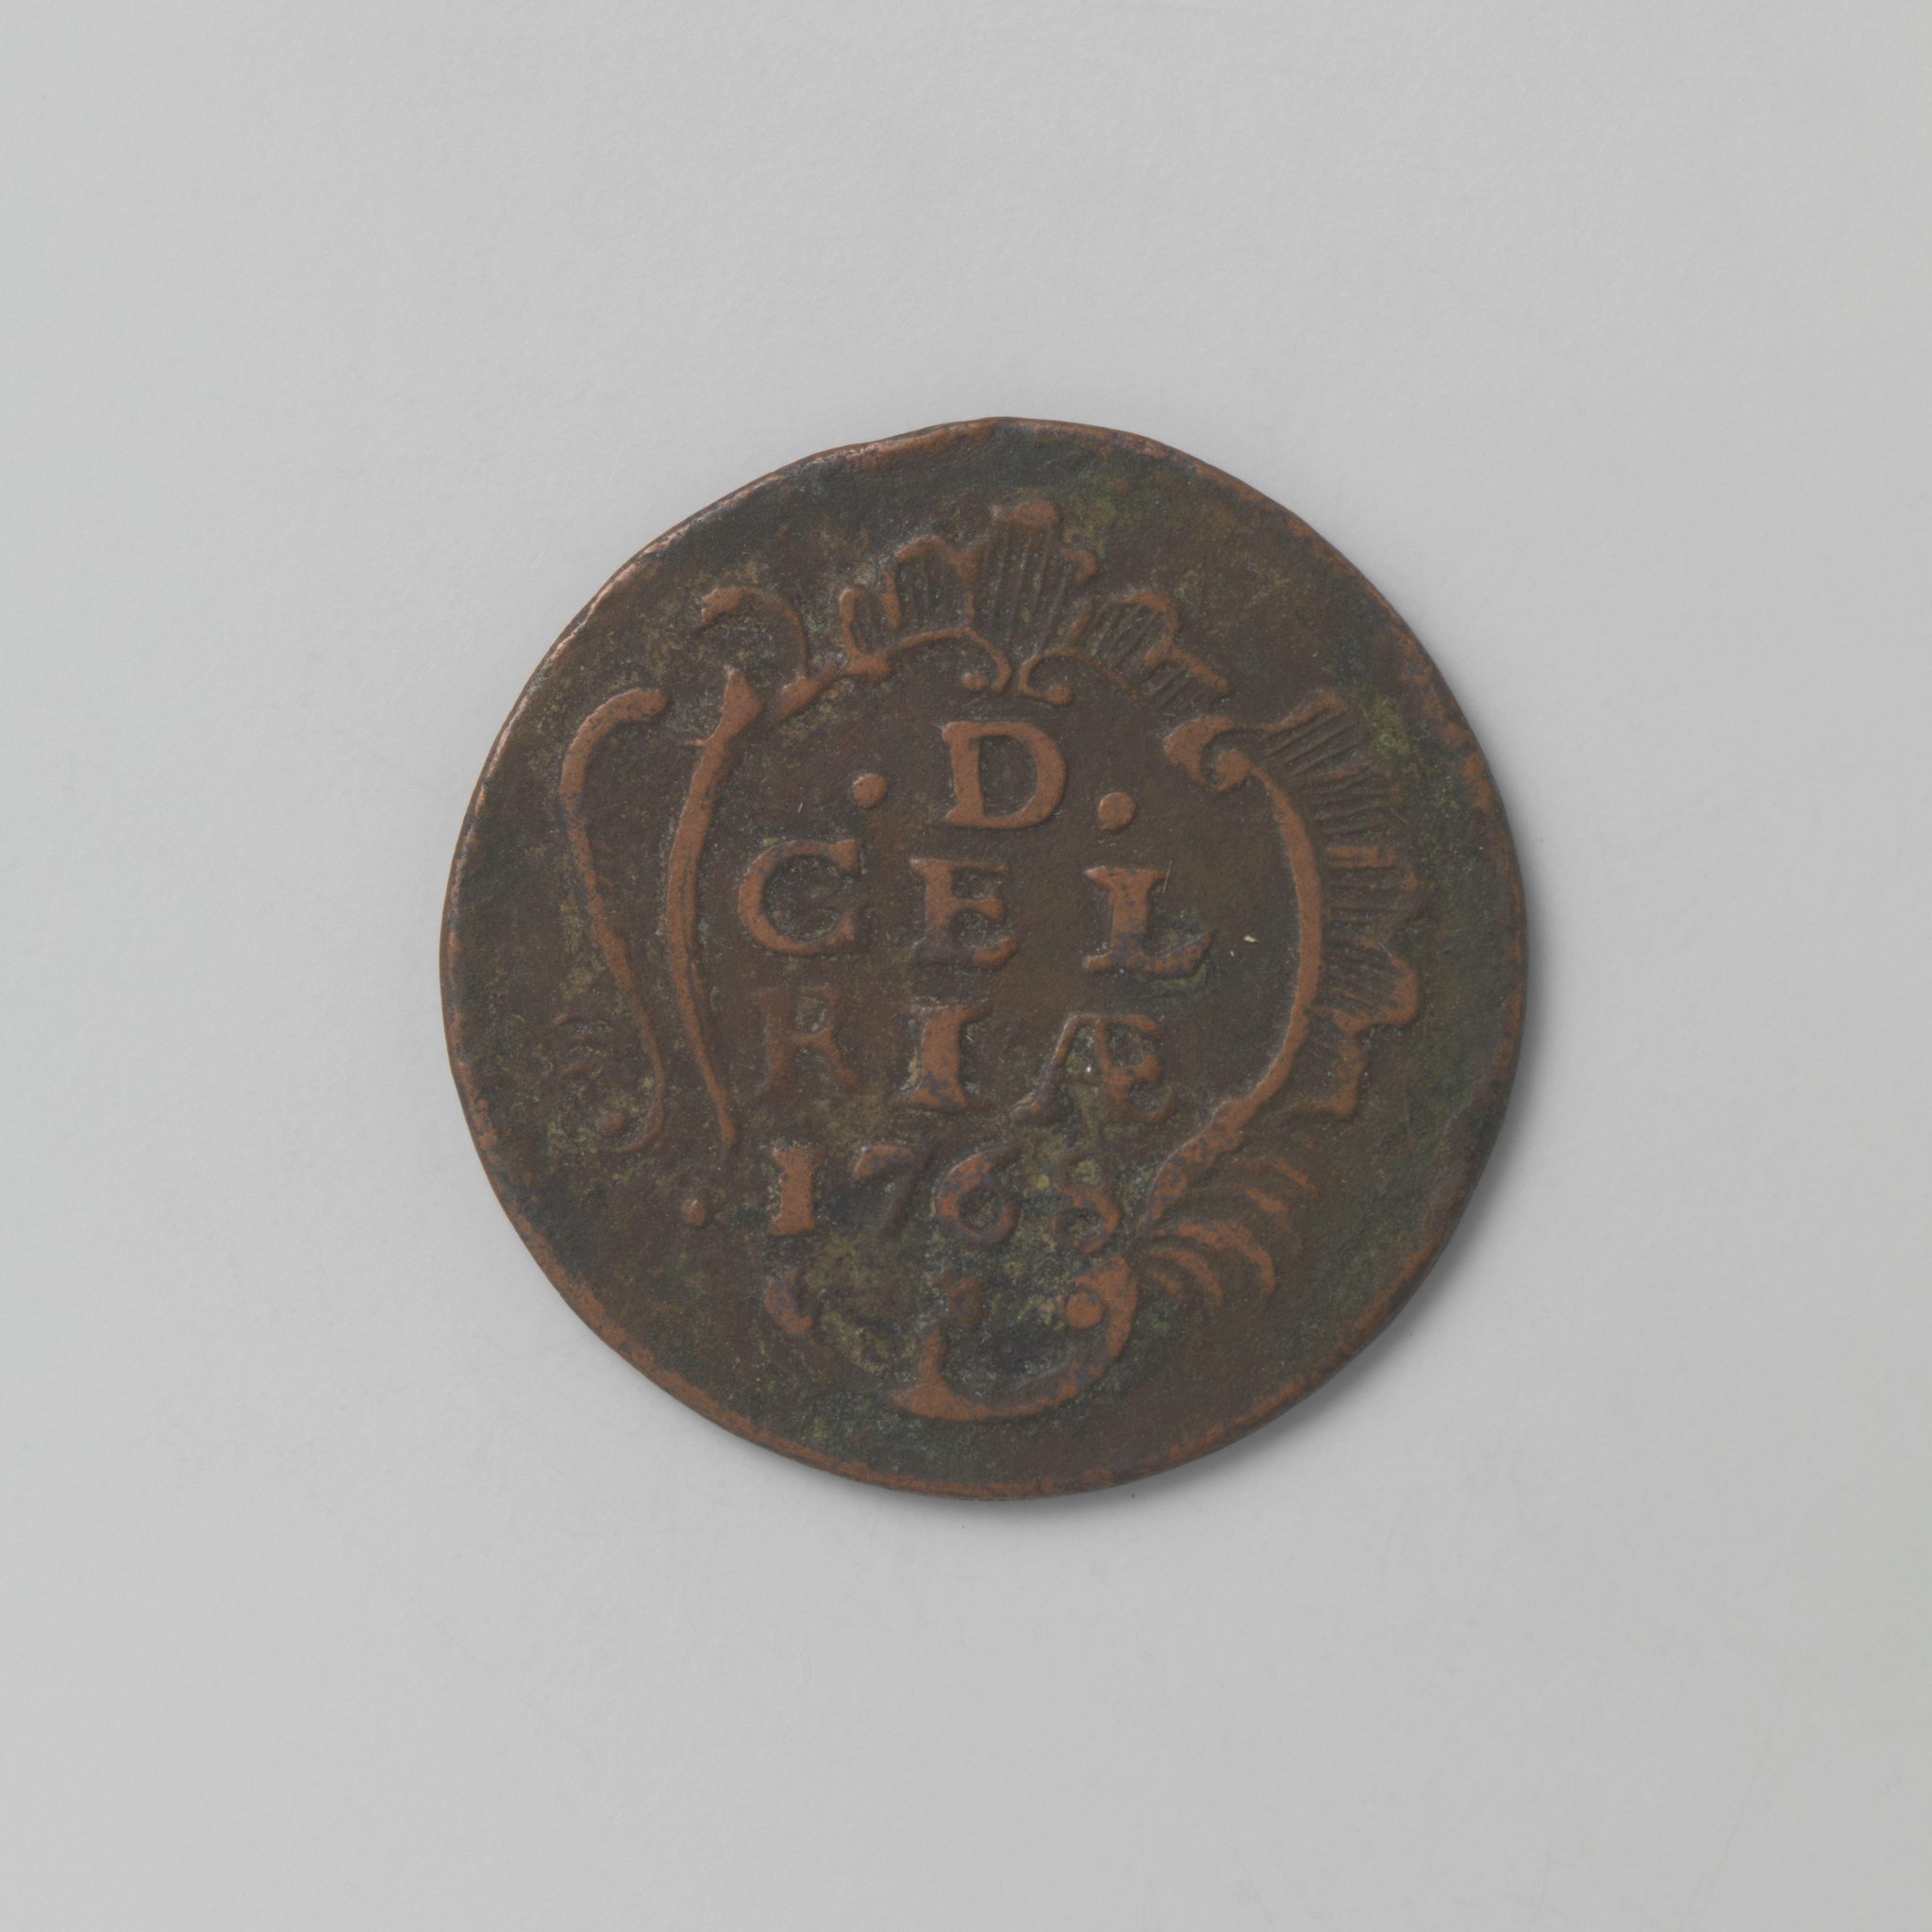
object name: duit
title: Gelderland, duit, 1768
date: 1768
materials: copper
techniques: striking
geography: harderwijk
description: Koperen munt. Voorzijde: binnen weelderige rococo-versiering in drie regels D/GEL/RIAE, daaronder jaartal en muntmeesterteken. Keerzijde: gekroond Gelders wapenschild.